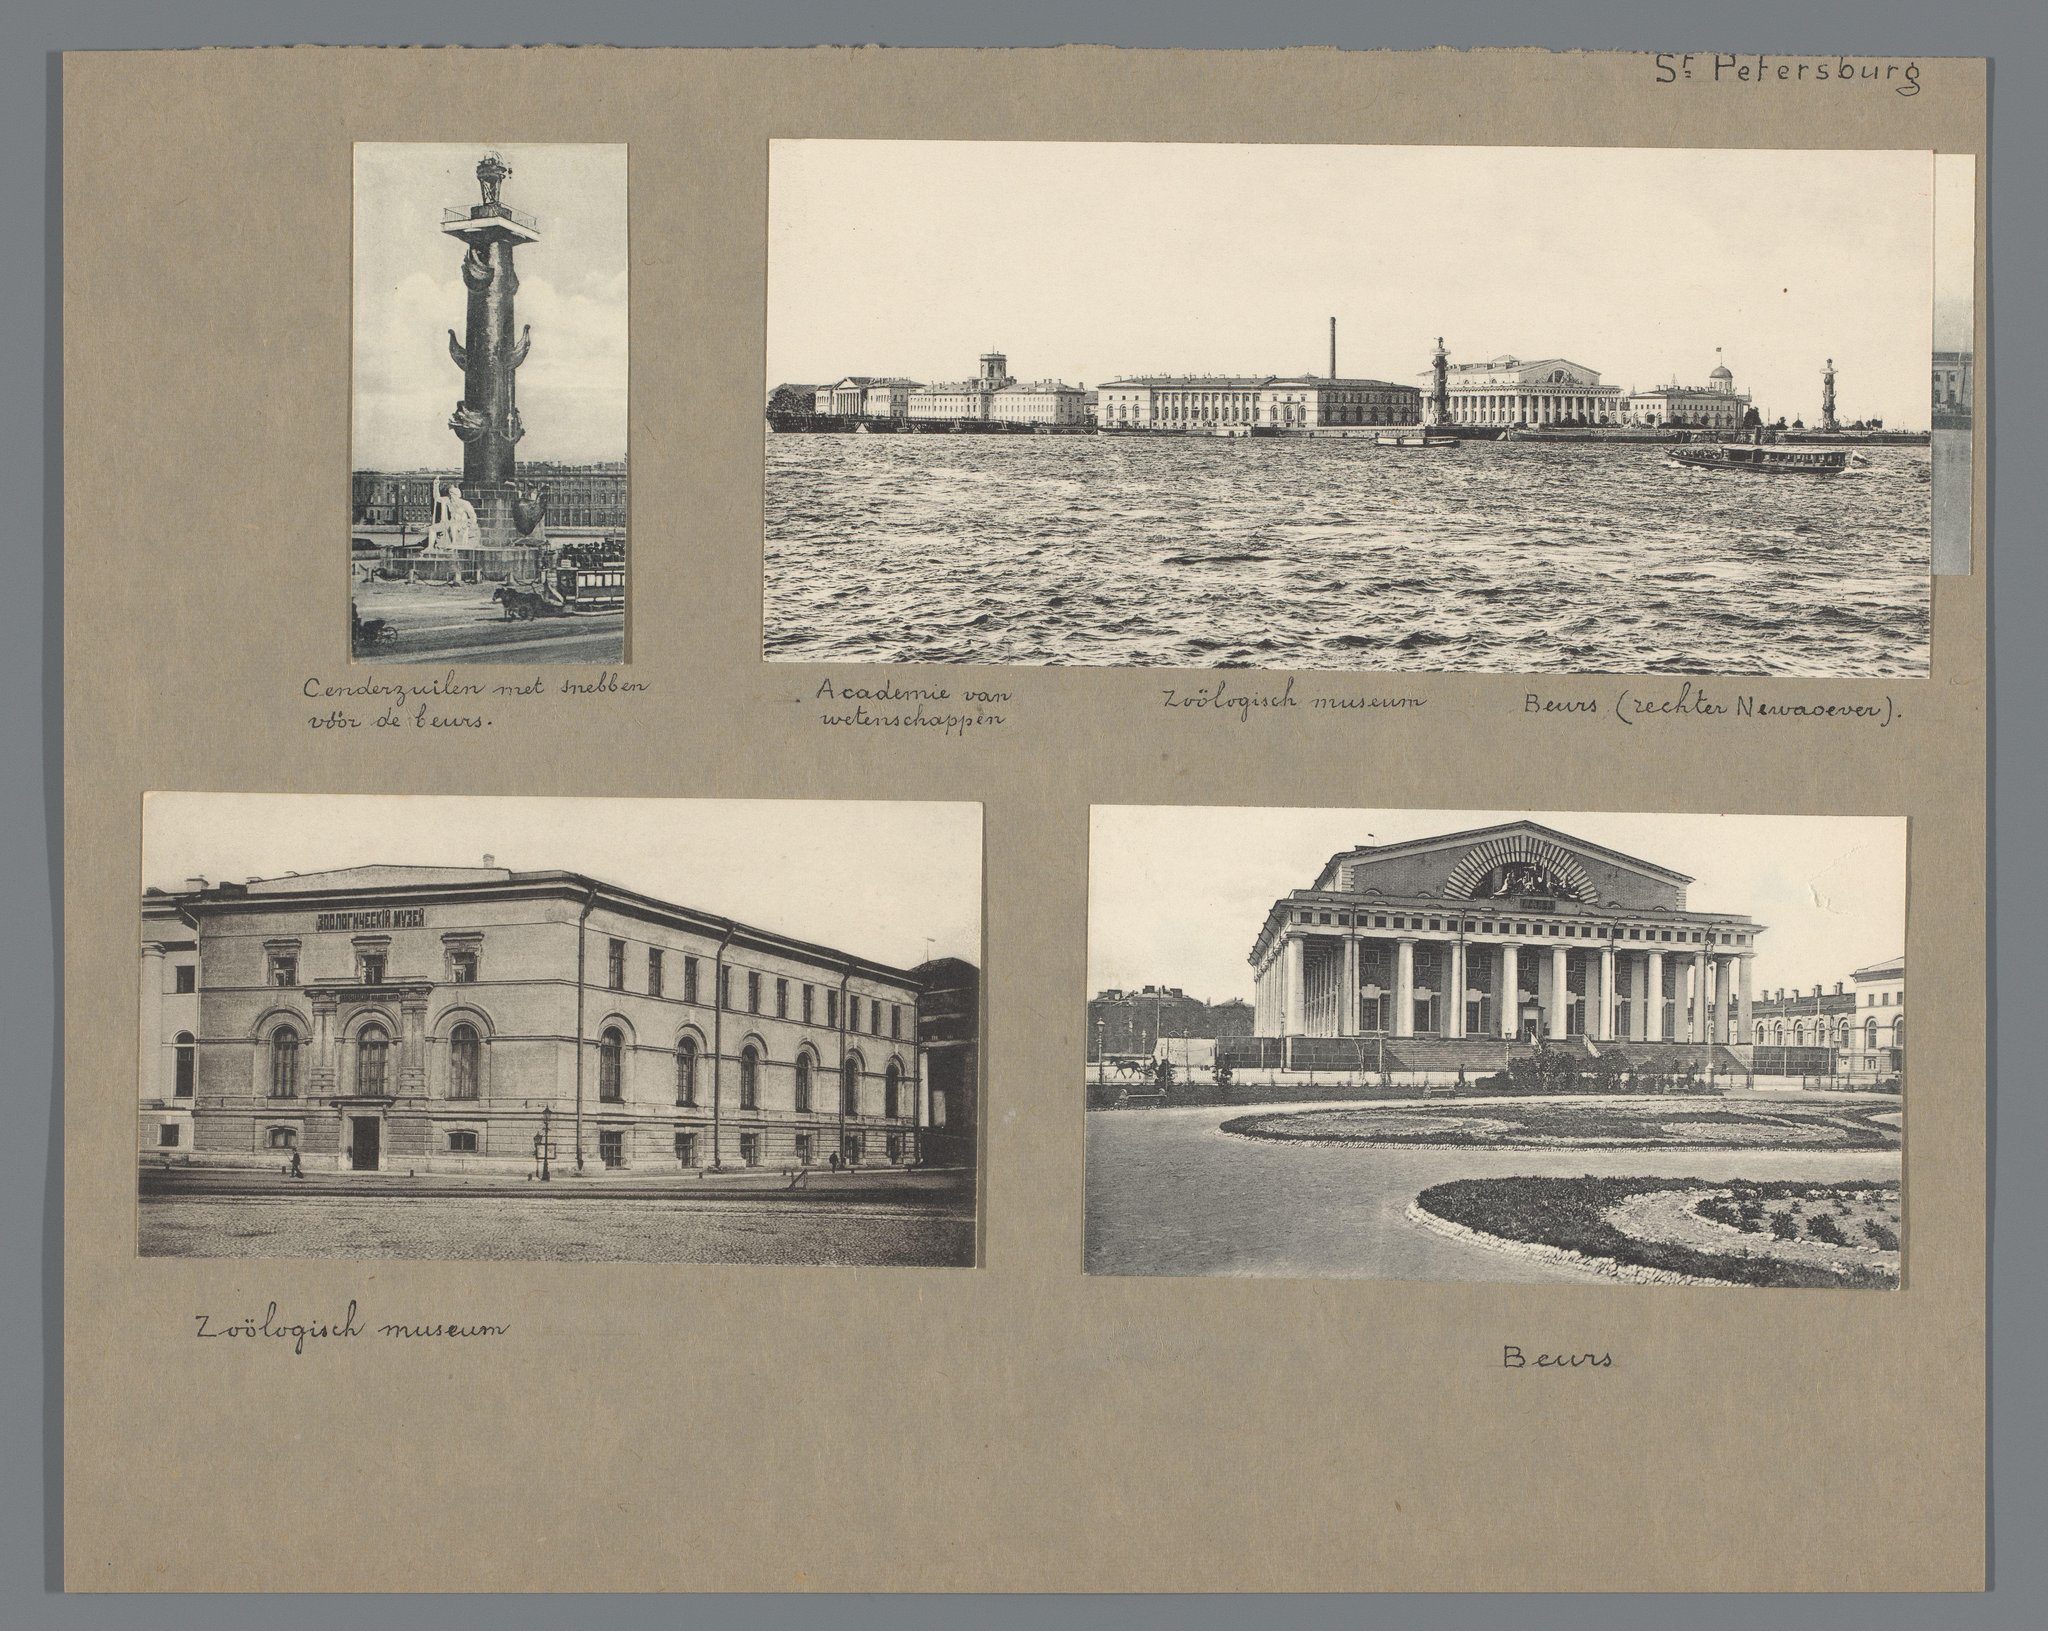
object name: photograph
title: St. Petersburg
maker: Anonymous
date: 1860-1925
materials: photographic support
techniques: photograph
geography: russia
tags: sint-petersburg